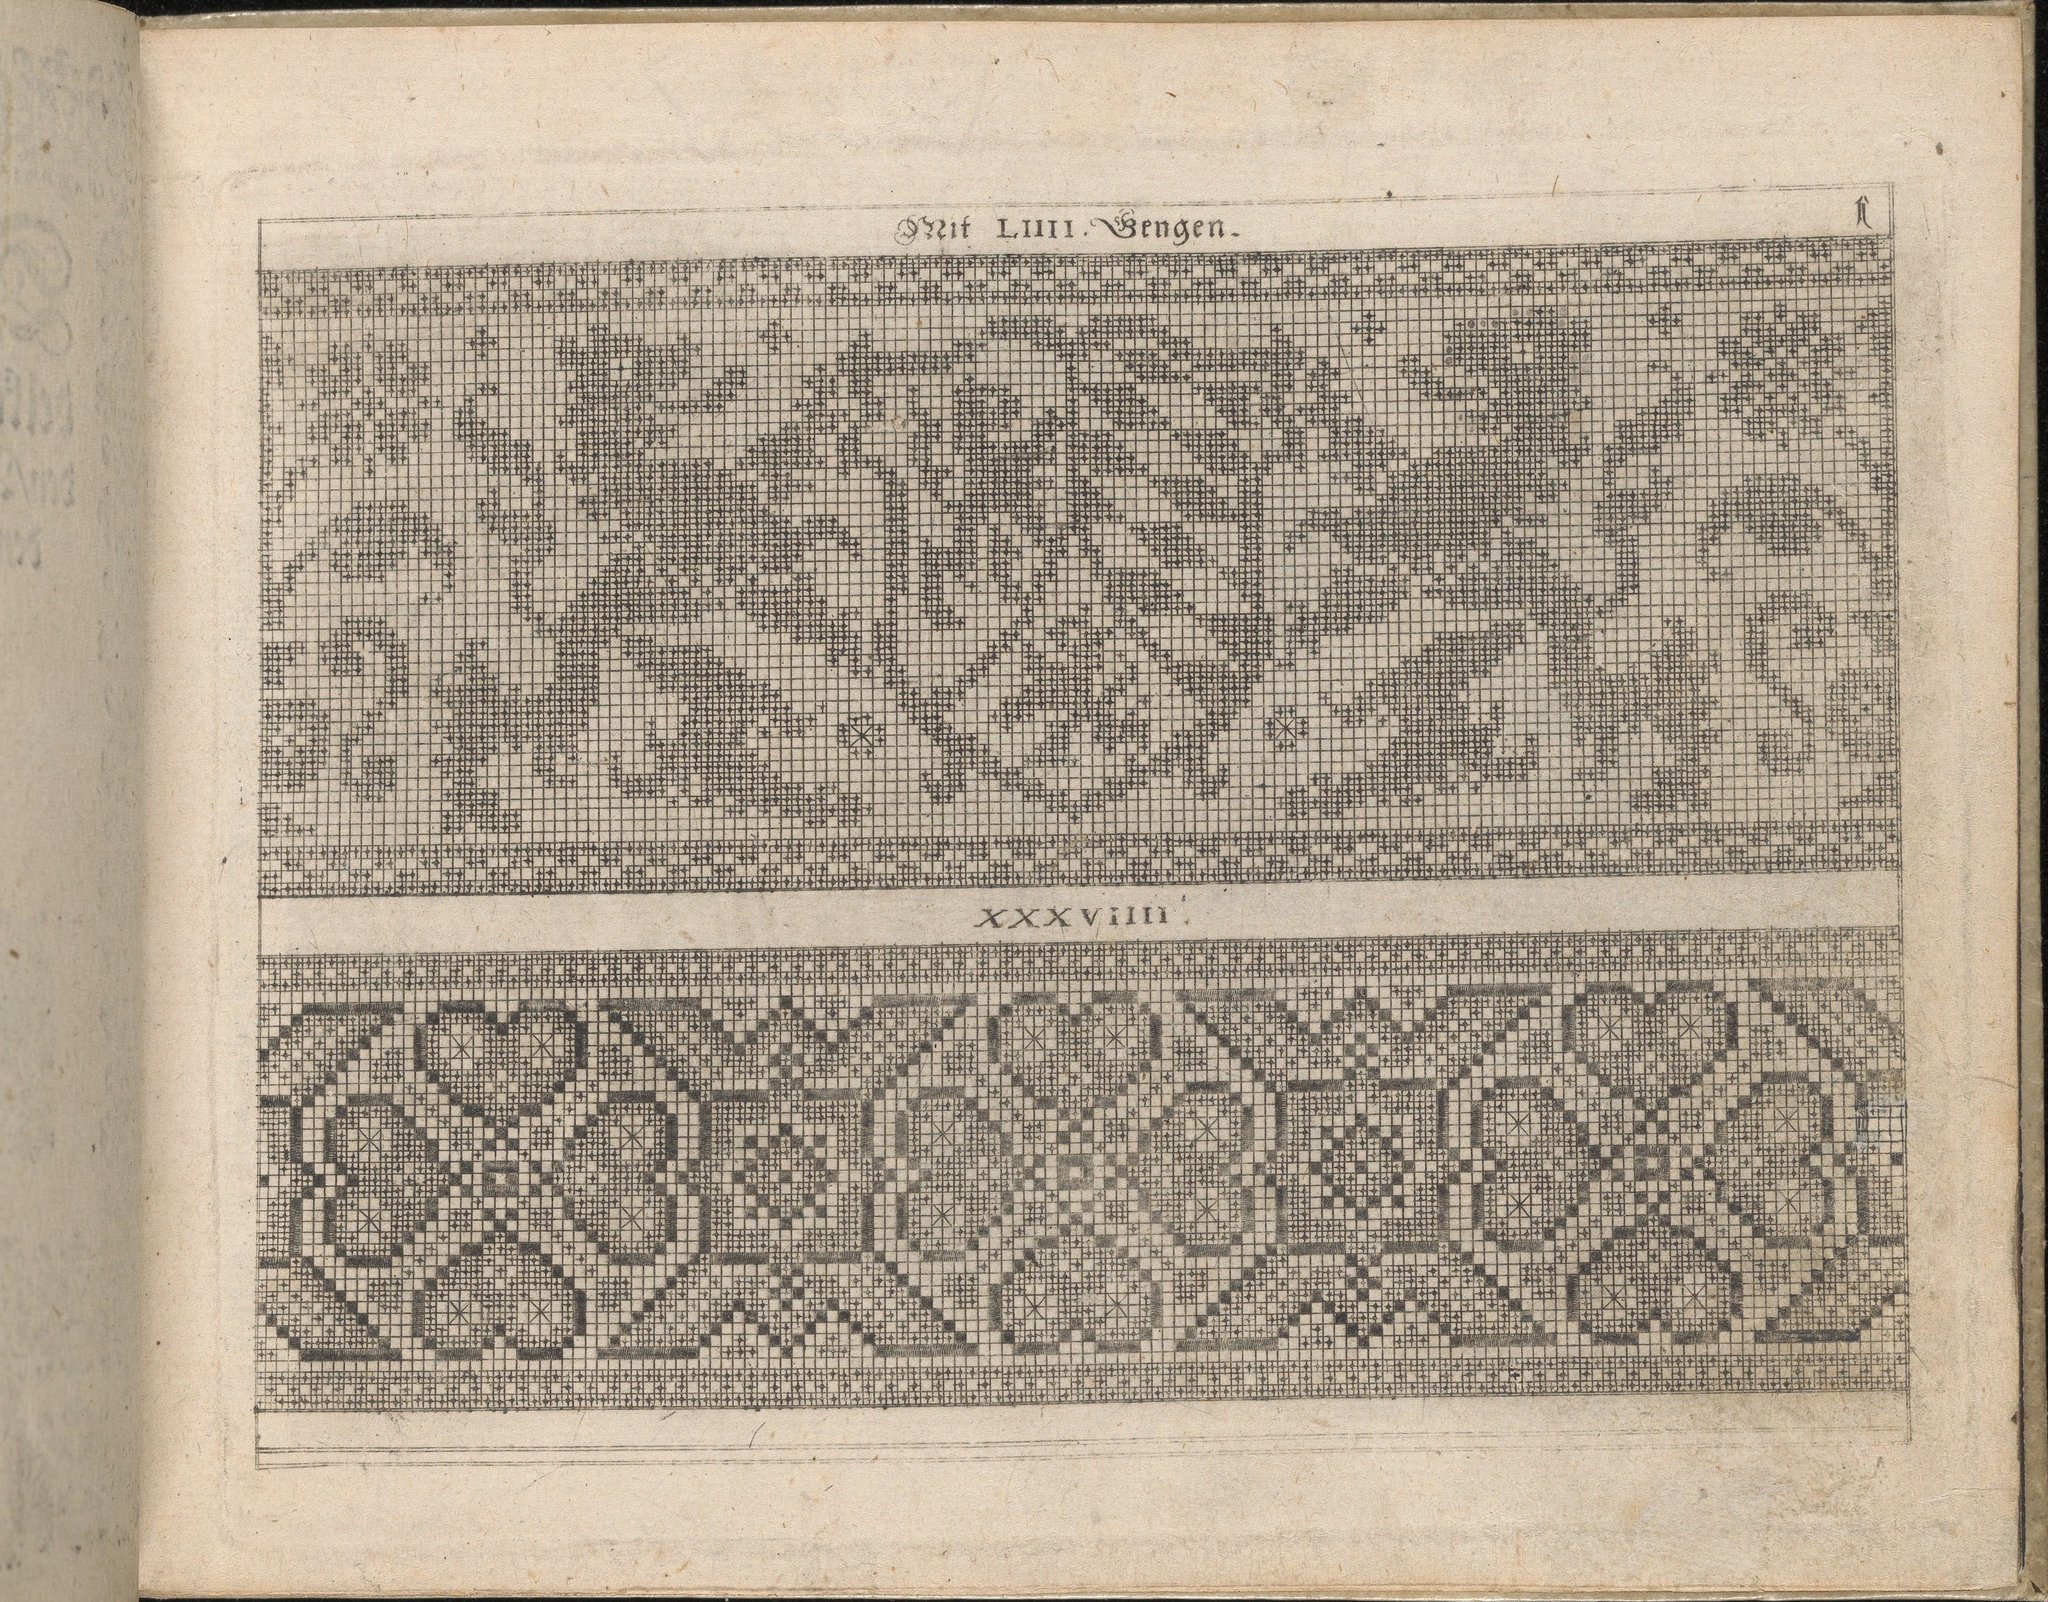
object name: book print ornament architecture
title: Newes Modelbuch in Kupffer (Page 10r)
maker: johann sibmacher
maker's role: artist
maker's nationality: german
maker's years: 1590-1611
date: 1604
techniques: etching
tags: coat of arms